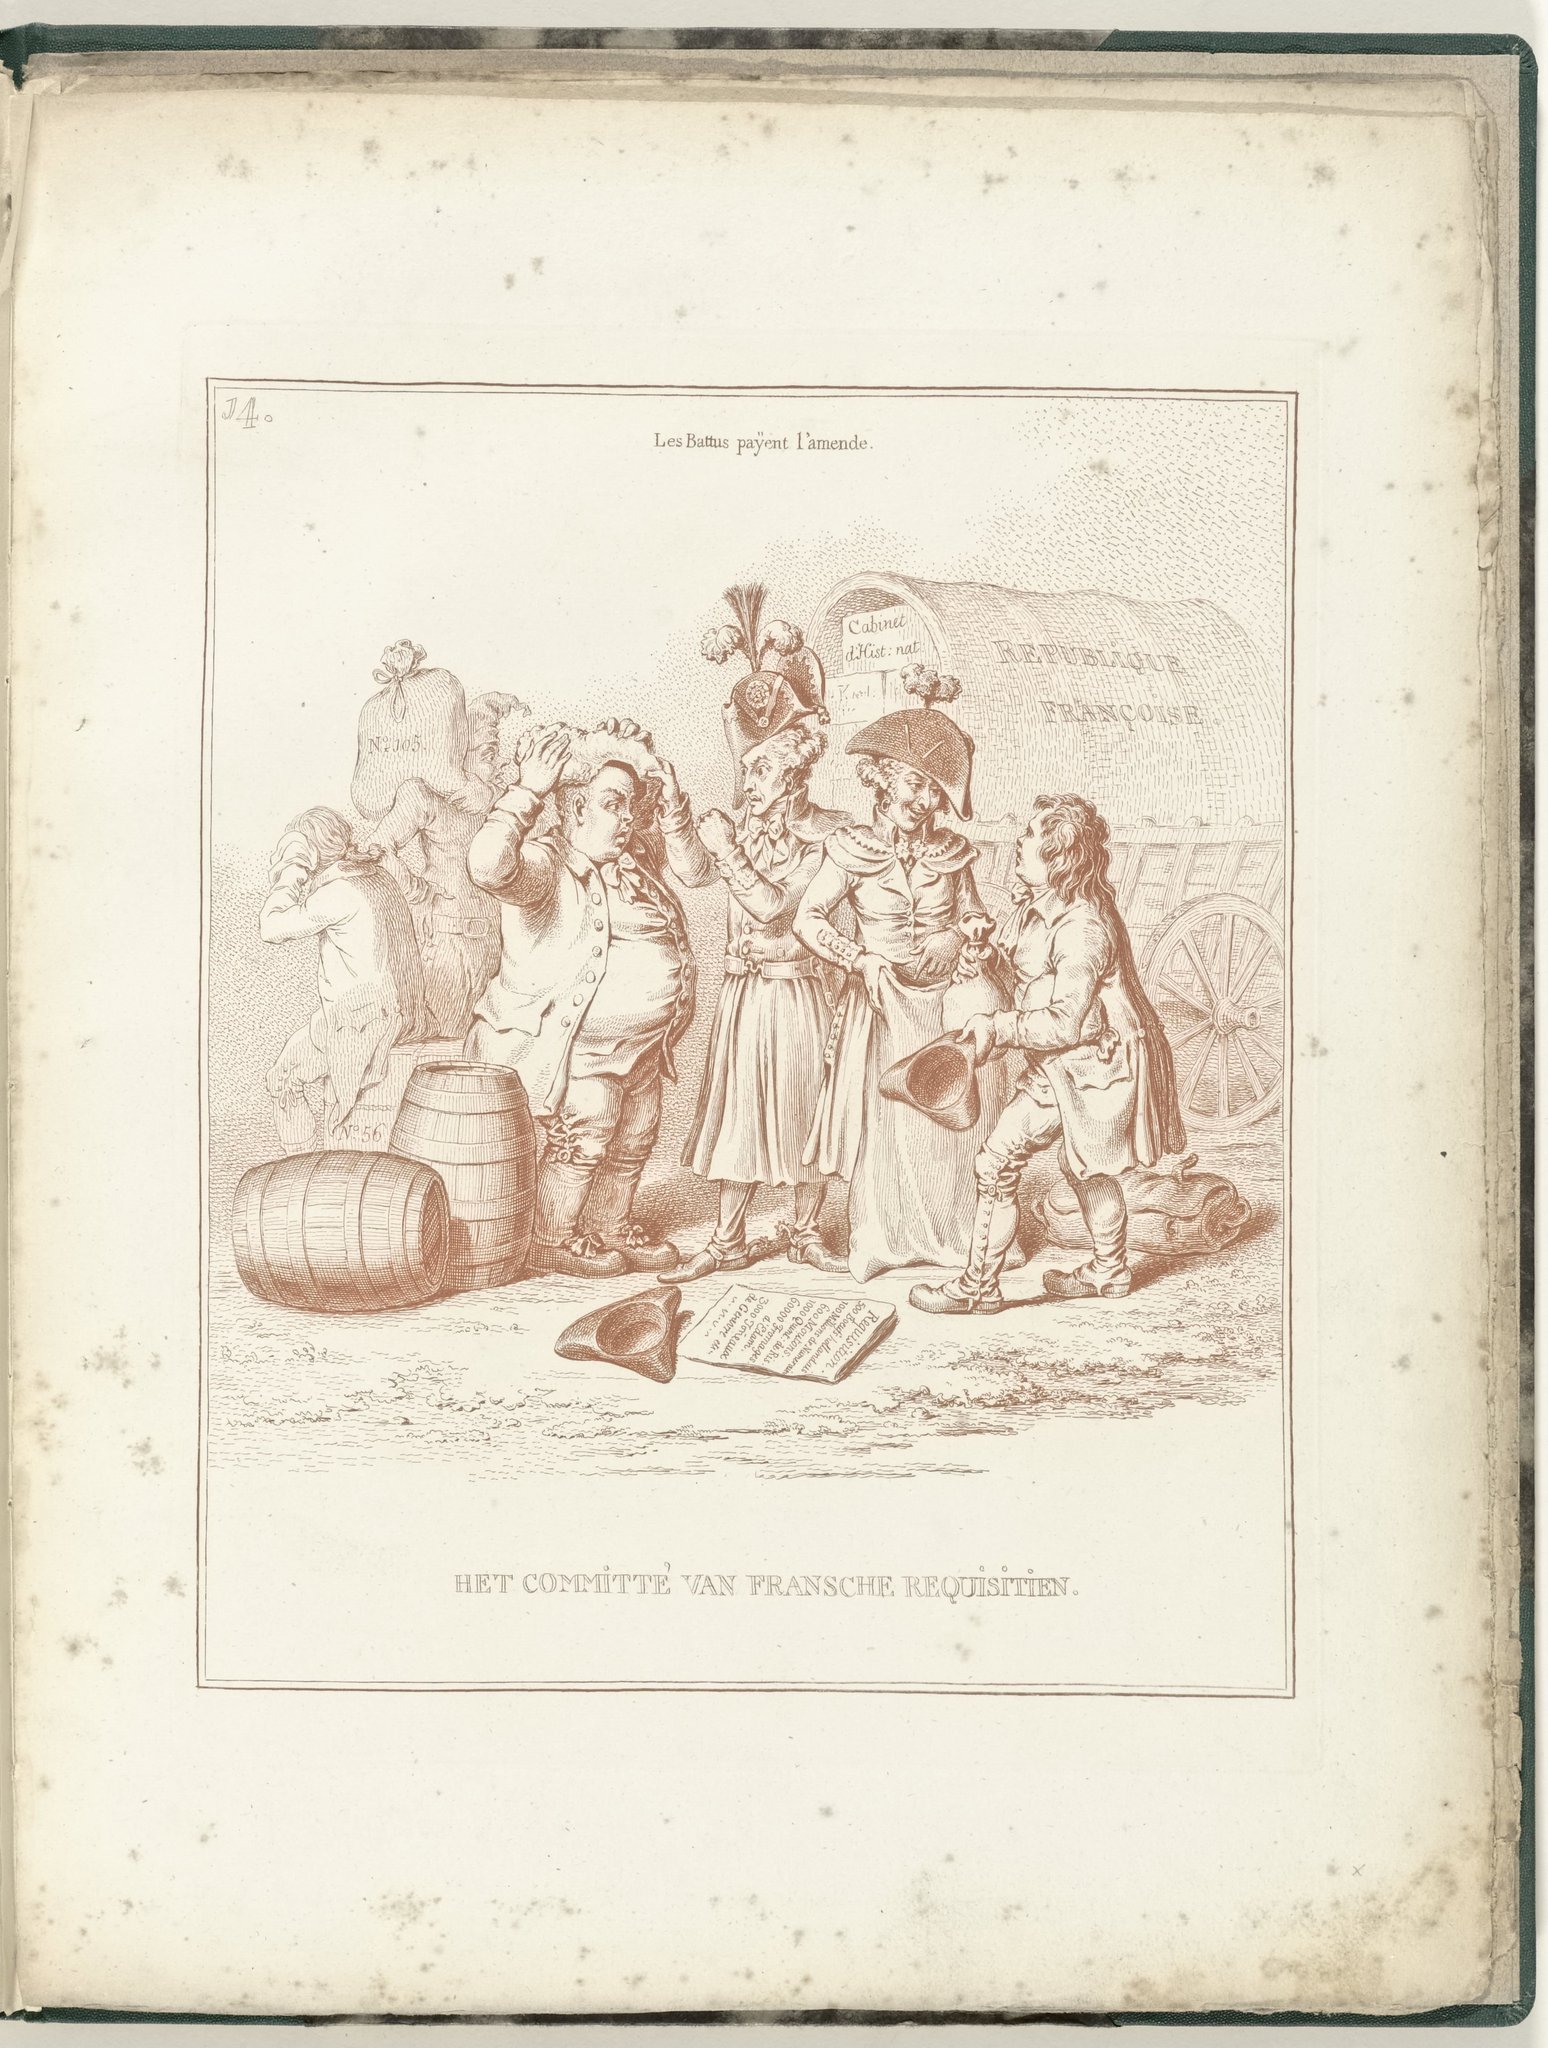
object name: cartoon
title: Het Committé van Fransche Requisitien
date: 1795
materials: paper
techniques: etching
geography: london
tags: seizure of goods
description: Onderdeel van een in boekvorm uitgegeven serie van twintig spotprenten op de Provisionele Representanten van het Volk van Holland en de Bataafse Republiek in het algemeen in het jaar 1795. De serietitel 'Hollandia Regenerata' staat vermeld op de titelprent. Elke prent gevolgd door een tekstblad met een Bijbelcitaat in het Nederlands, een verklaring in het Frans en het Bijbelcitaat in het Engels. Waarschijnlijk uitgegeven in Londen door William Humphrey in 1795.